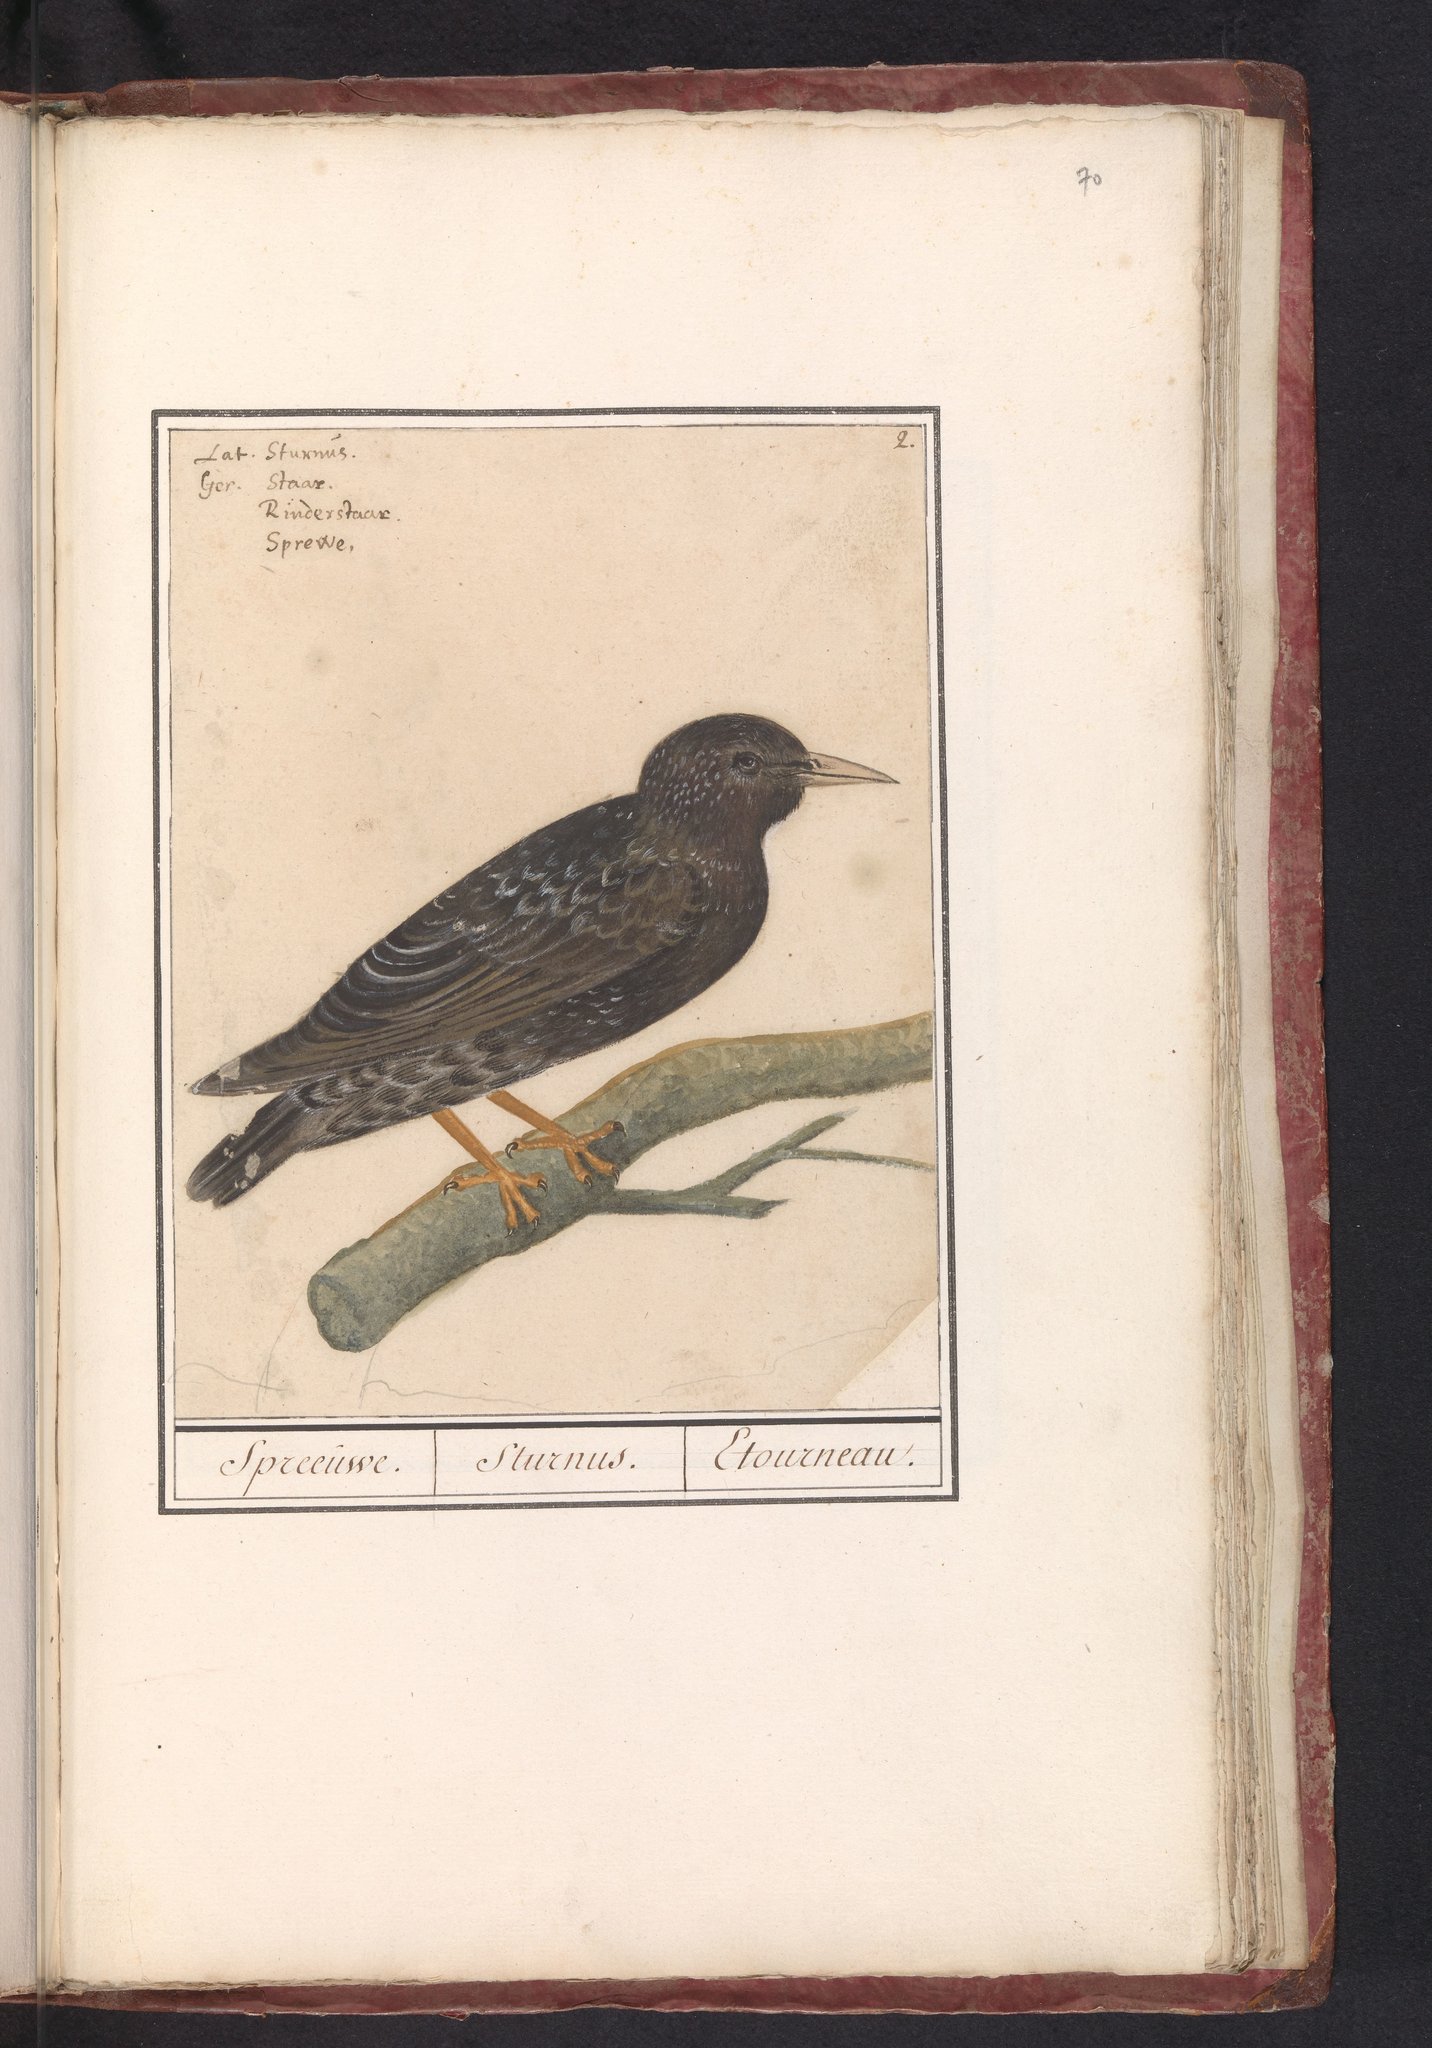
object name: drawing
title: Spreeuw (Sturnus vulgaris)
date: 1596-1610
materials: paint, ink, paper, pencil, watercolor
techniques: brush, pen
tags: song-birds: starling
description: Spreeuw. Genummerd rechtsboven: 2. Linksboven de naam in vier talen. Onderdeel van het eerste album met tekeningen van vogels. Derde van twaalf albums met tekeningen van dieren, vogels en planten bekend rond 1600, gemaakt in opdracht van keizer Rudolf II. Met toelichting in Nederlands, Latijn en Frans.